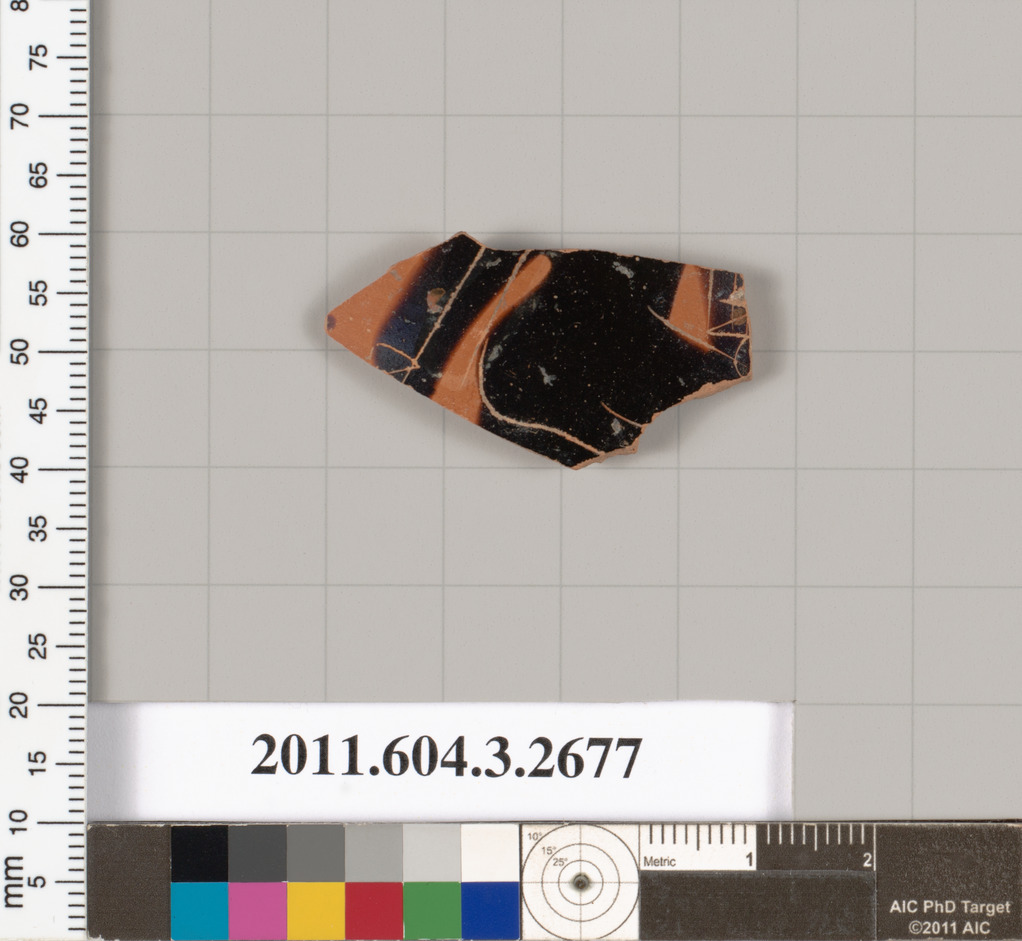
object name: oinochoe or olpe fragment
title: Terracotta fragment of an oinochoe (jug) or olpe (jug)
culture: greek, attic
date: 534-468 BCE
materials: terracotta